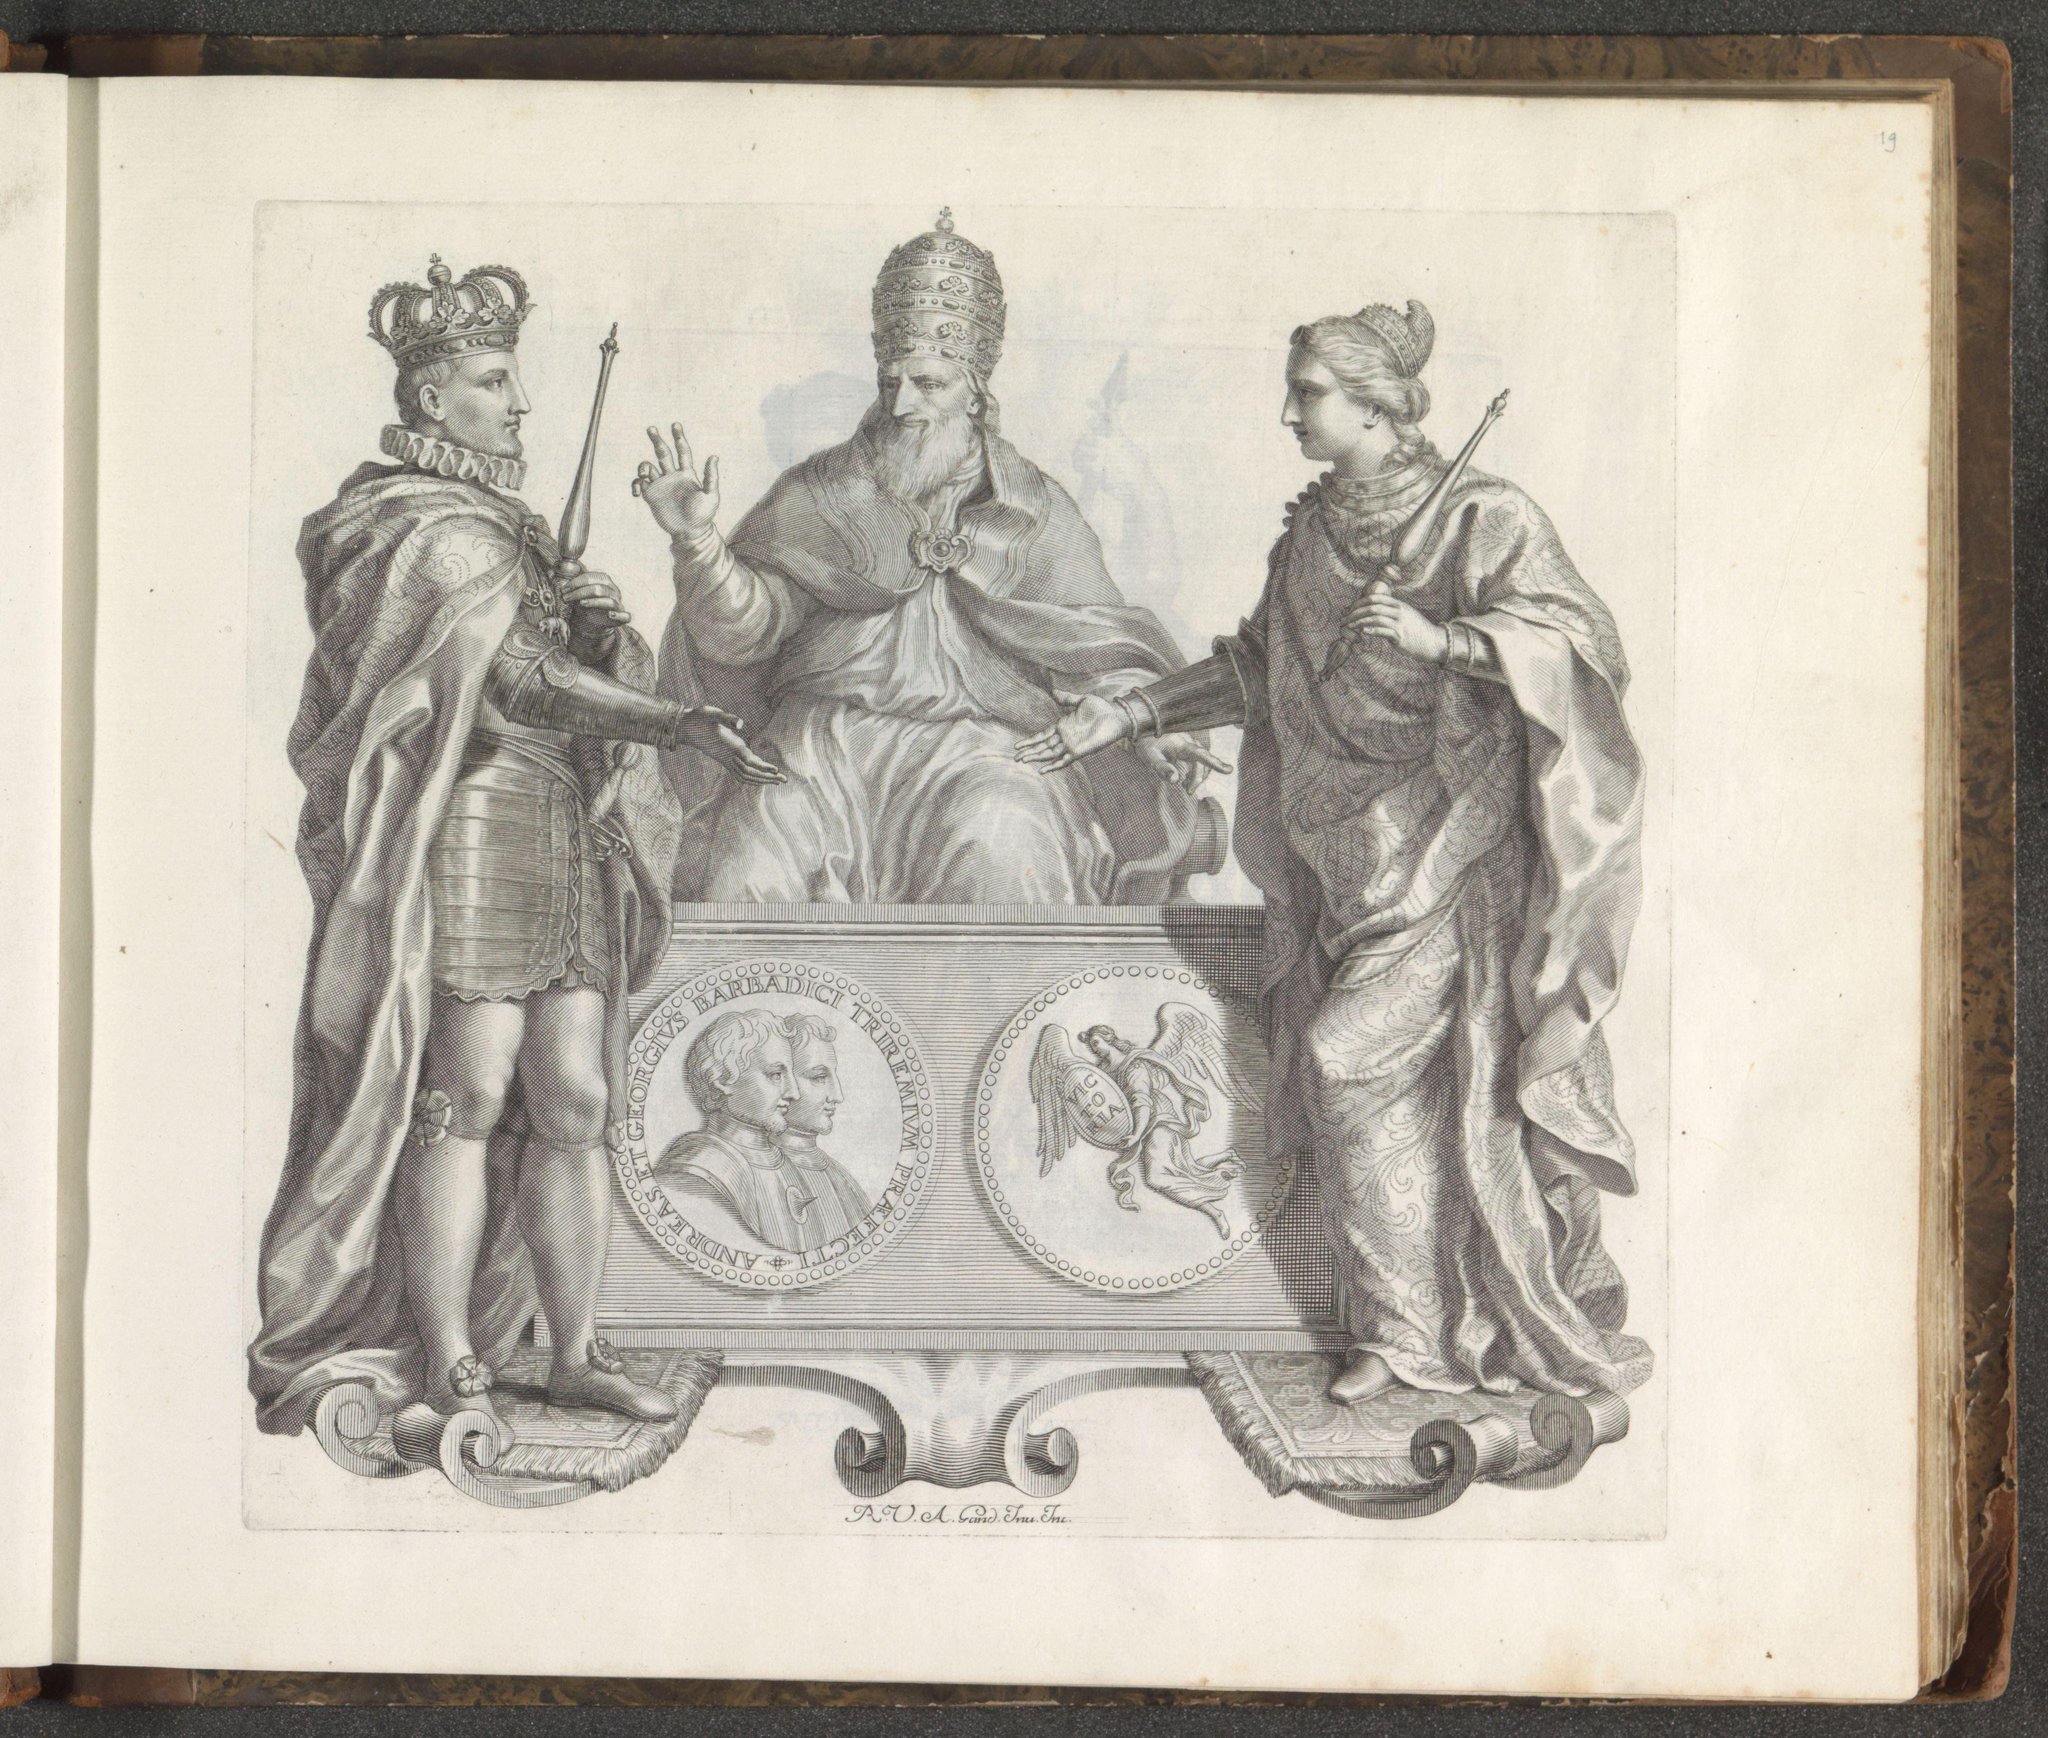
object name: album leaf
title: Numismata virorum illustrium ex Barbadica gente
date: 1673-1743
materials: paper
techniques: engraving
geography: rome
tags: medal (considered as a piece of sculpture, regardless of its specific function), other sovereign: doge, pope, king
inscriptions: collector's mark: Lugt 2228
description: Voetstuk in de vorm van een cartouche. Daarop een medaillon met op de voorzijde de portretten van Andrea en Giorgio Barbarigo. Zij dragen een kuras of borstharnas. Op de achterzijde Victoria. Het voetstuk wordt omringd door de Spaanse koning (Filips II?), de paus en de vrouwelijke personificatie van Venetië (als dogana met dogehoed). De koning en de dogana reiken elkaar de hand. De prent maakt deel uit van een album.